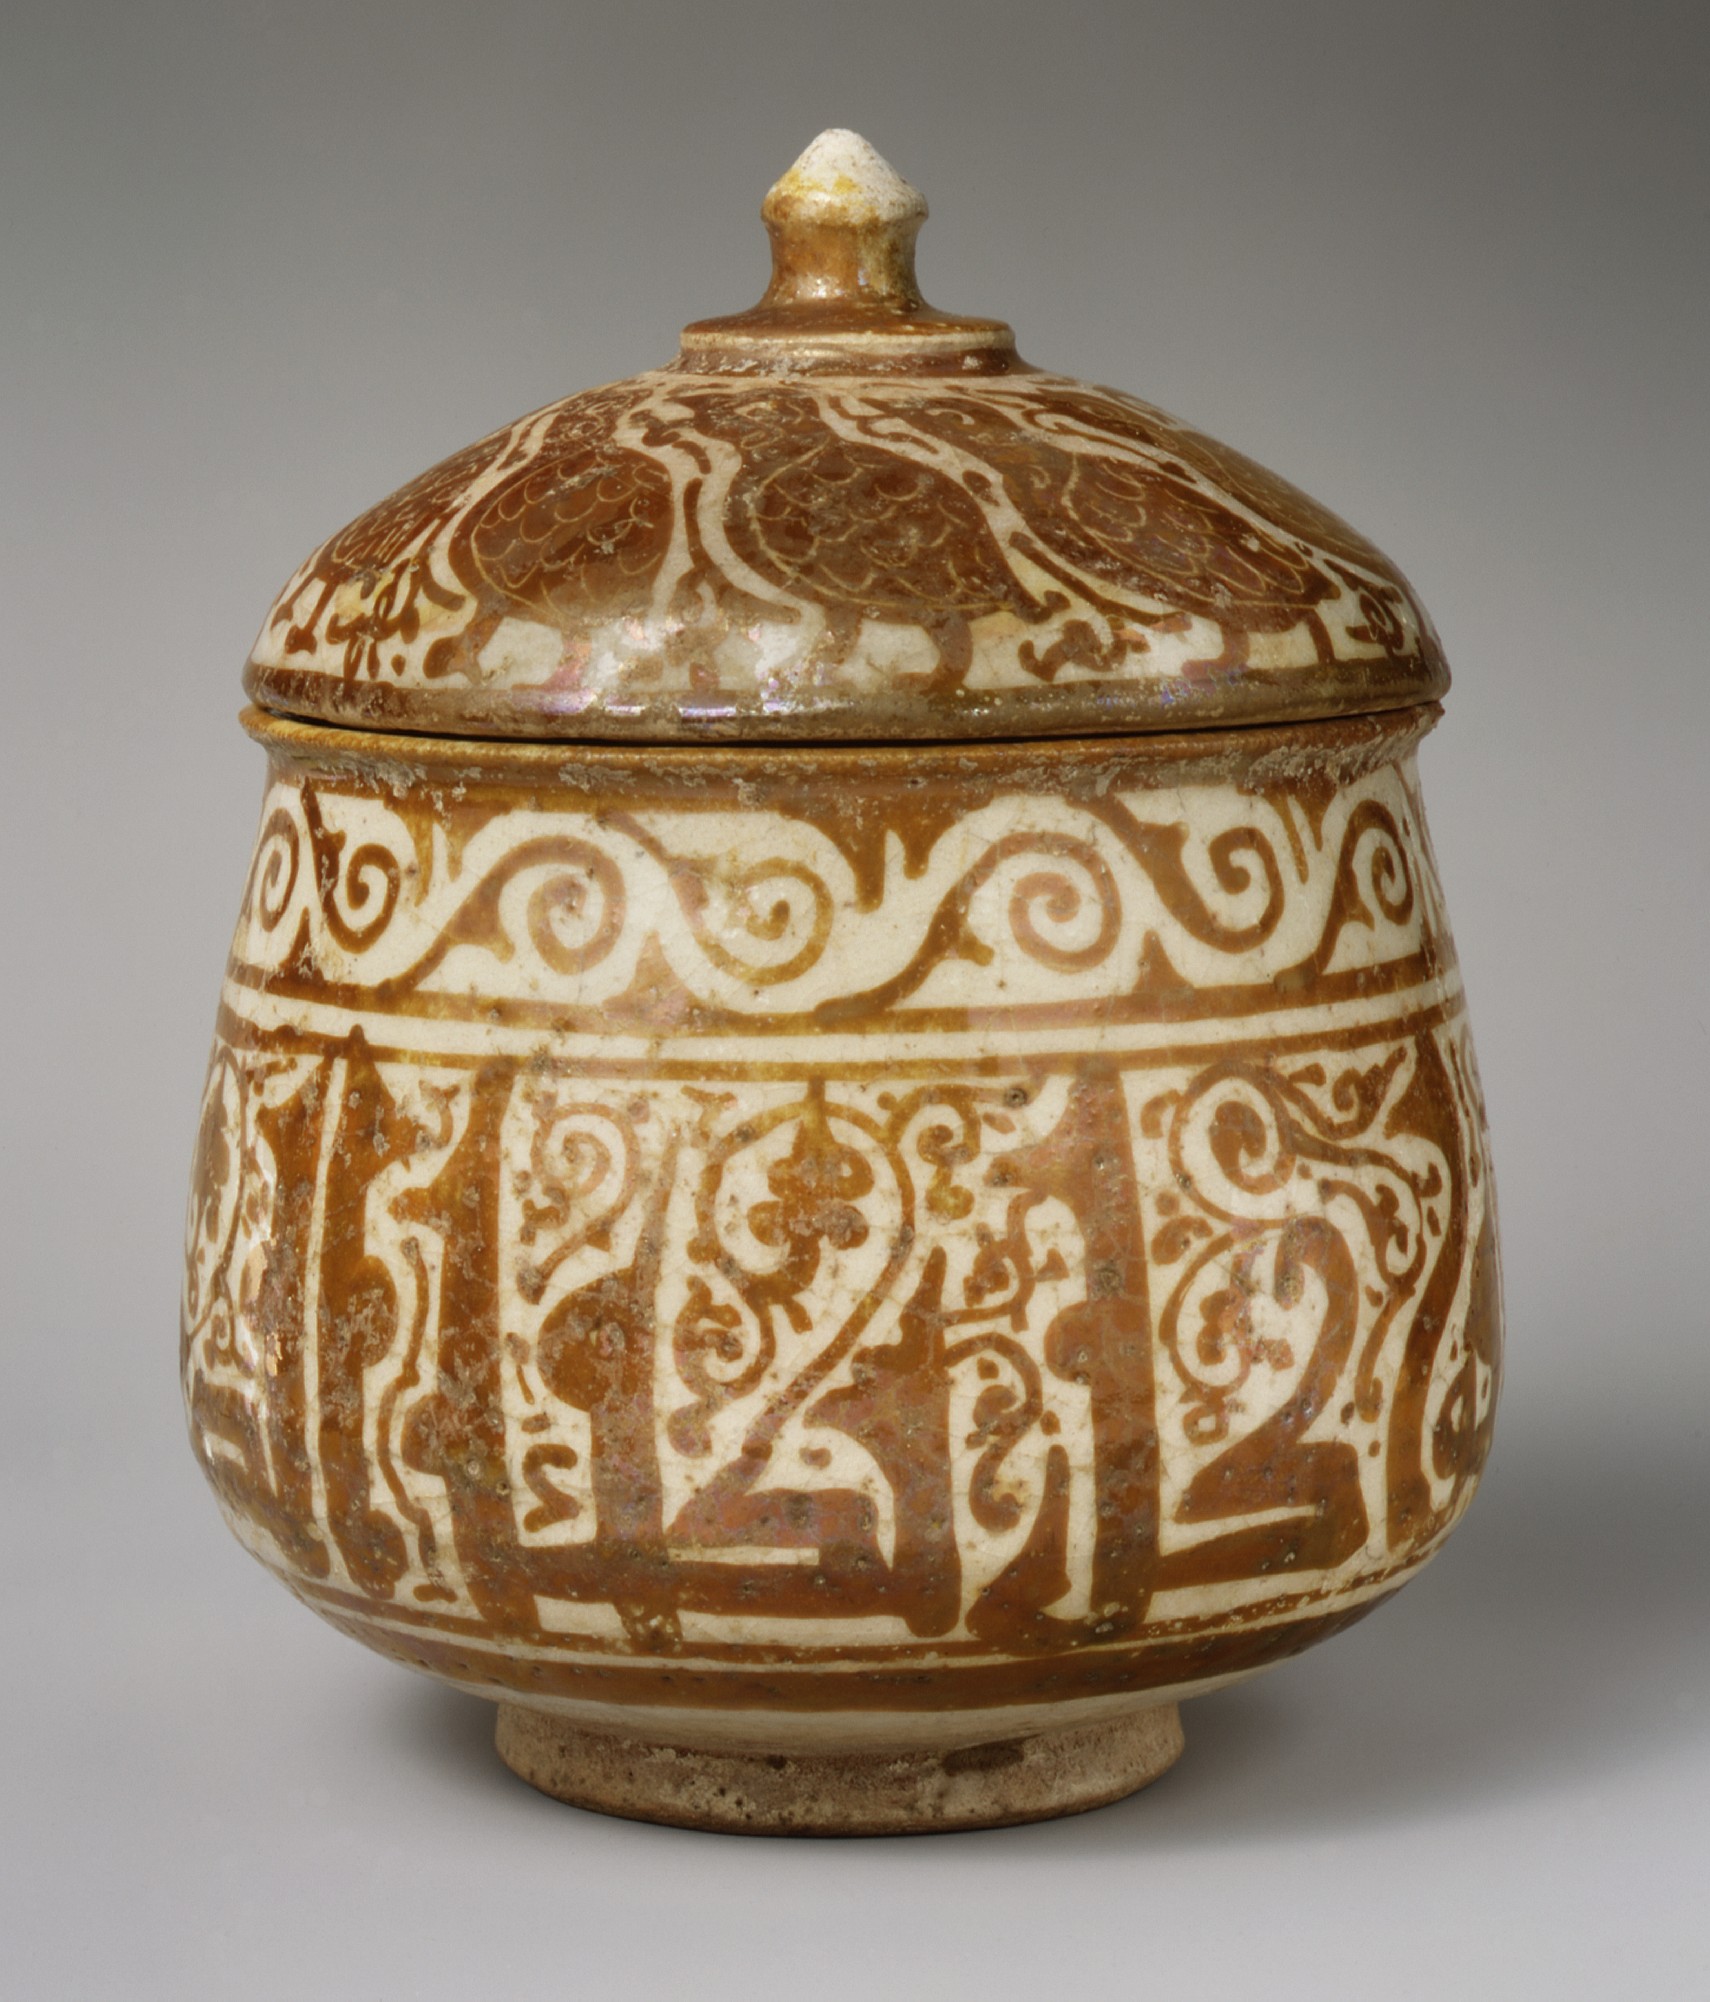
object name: pyxis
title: Pyxis (Cylindrical Container)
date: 1067-1133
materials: glaze, stonepaste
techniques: incising, luster painting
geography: syria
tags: arabic